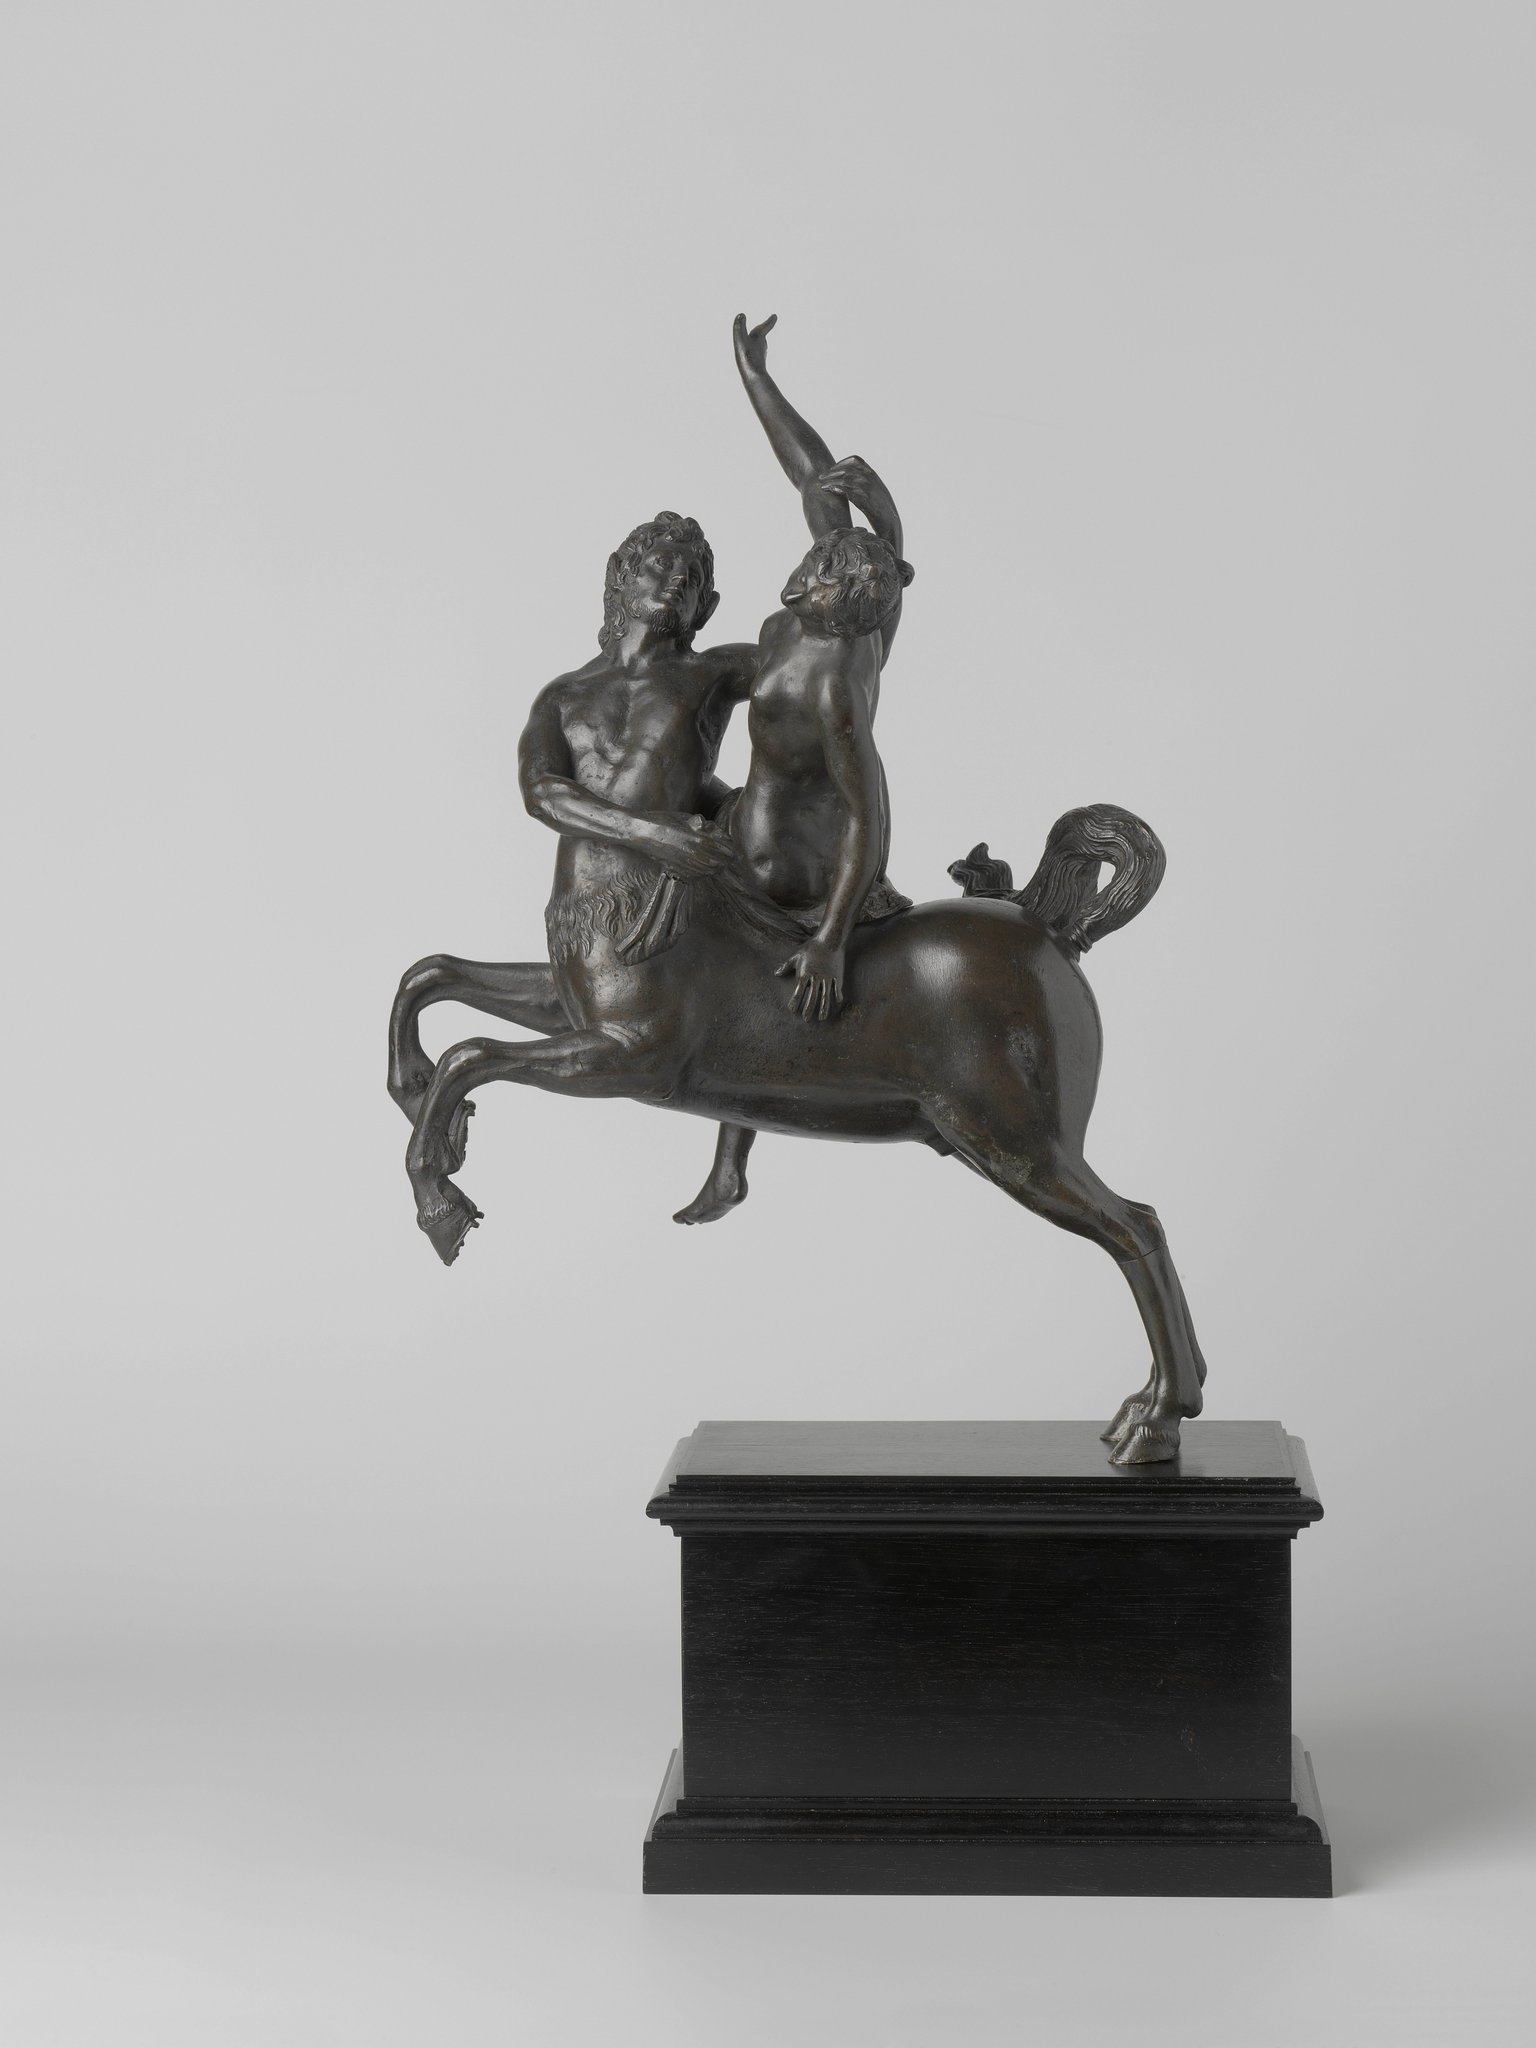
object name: sculpture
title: Nessus schaakt Deianeira op sokkel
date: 1500-1800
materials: bronze, marble, stone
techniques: polish, carved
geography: innsbruck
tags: nessus